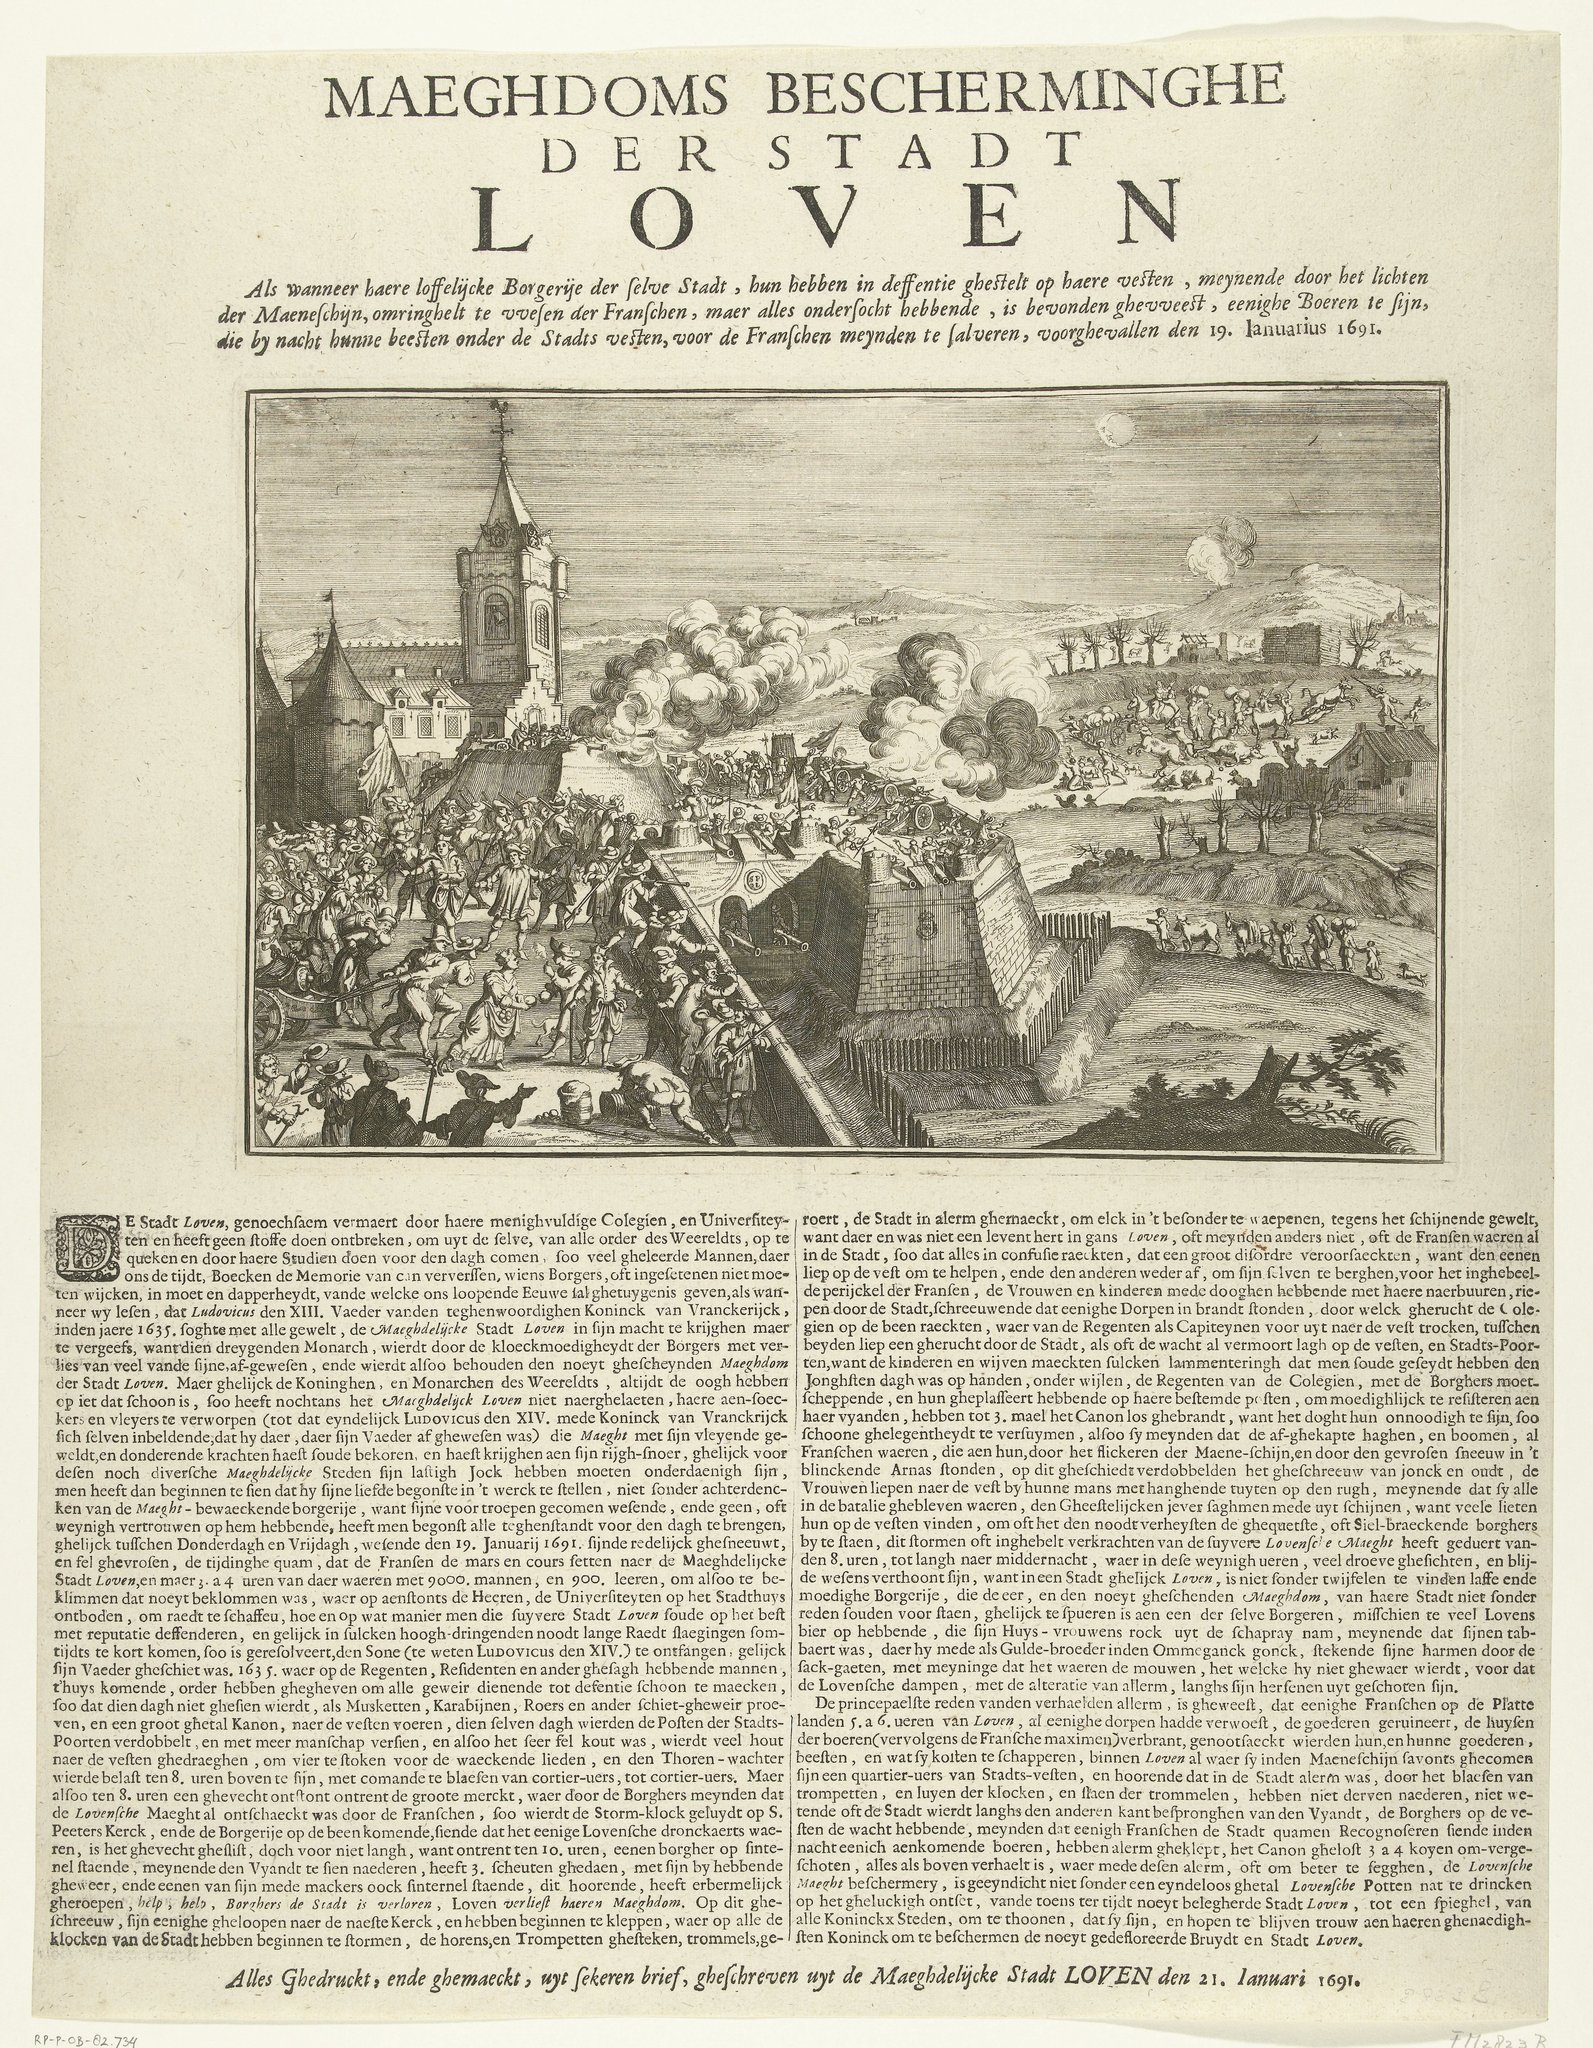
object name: print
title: Spotprent op de Leuvense koeienschutters, 1691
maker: Anonymous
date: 1691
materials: paper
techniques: etching, letterpress printing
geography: low countries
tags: counter-attack from a fortification ~ siege, louvain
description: Spotprent op de Leuvense koeienschutters. Bij avondalarm snelt de bevolking van Leuven naar de stadswallen in de veronderstelling dat het Franse leger in aantocht is. Kanonnen schieten op de vermeende vijand die slechts blijkt te bestaan uit enige boeren met hun koeien, 19 januari 1691. Onder de plaat een beschrijving in 2 kolommen.